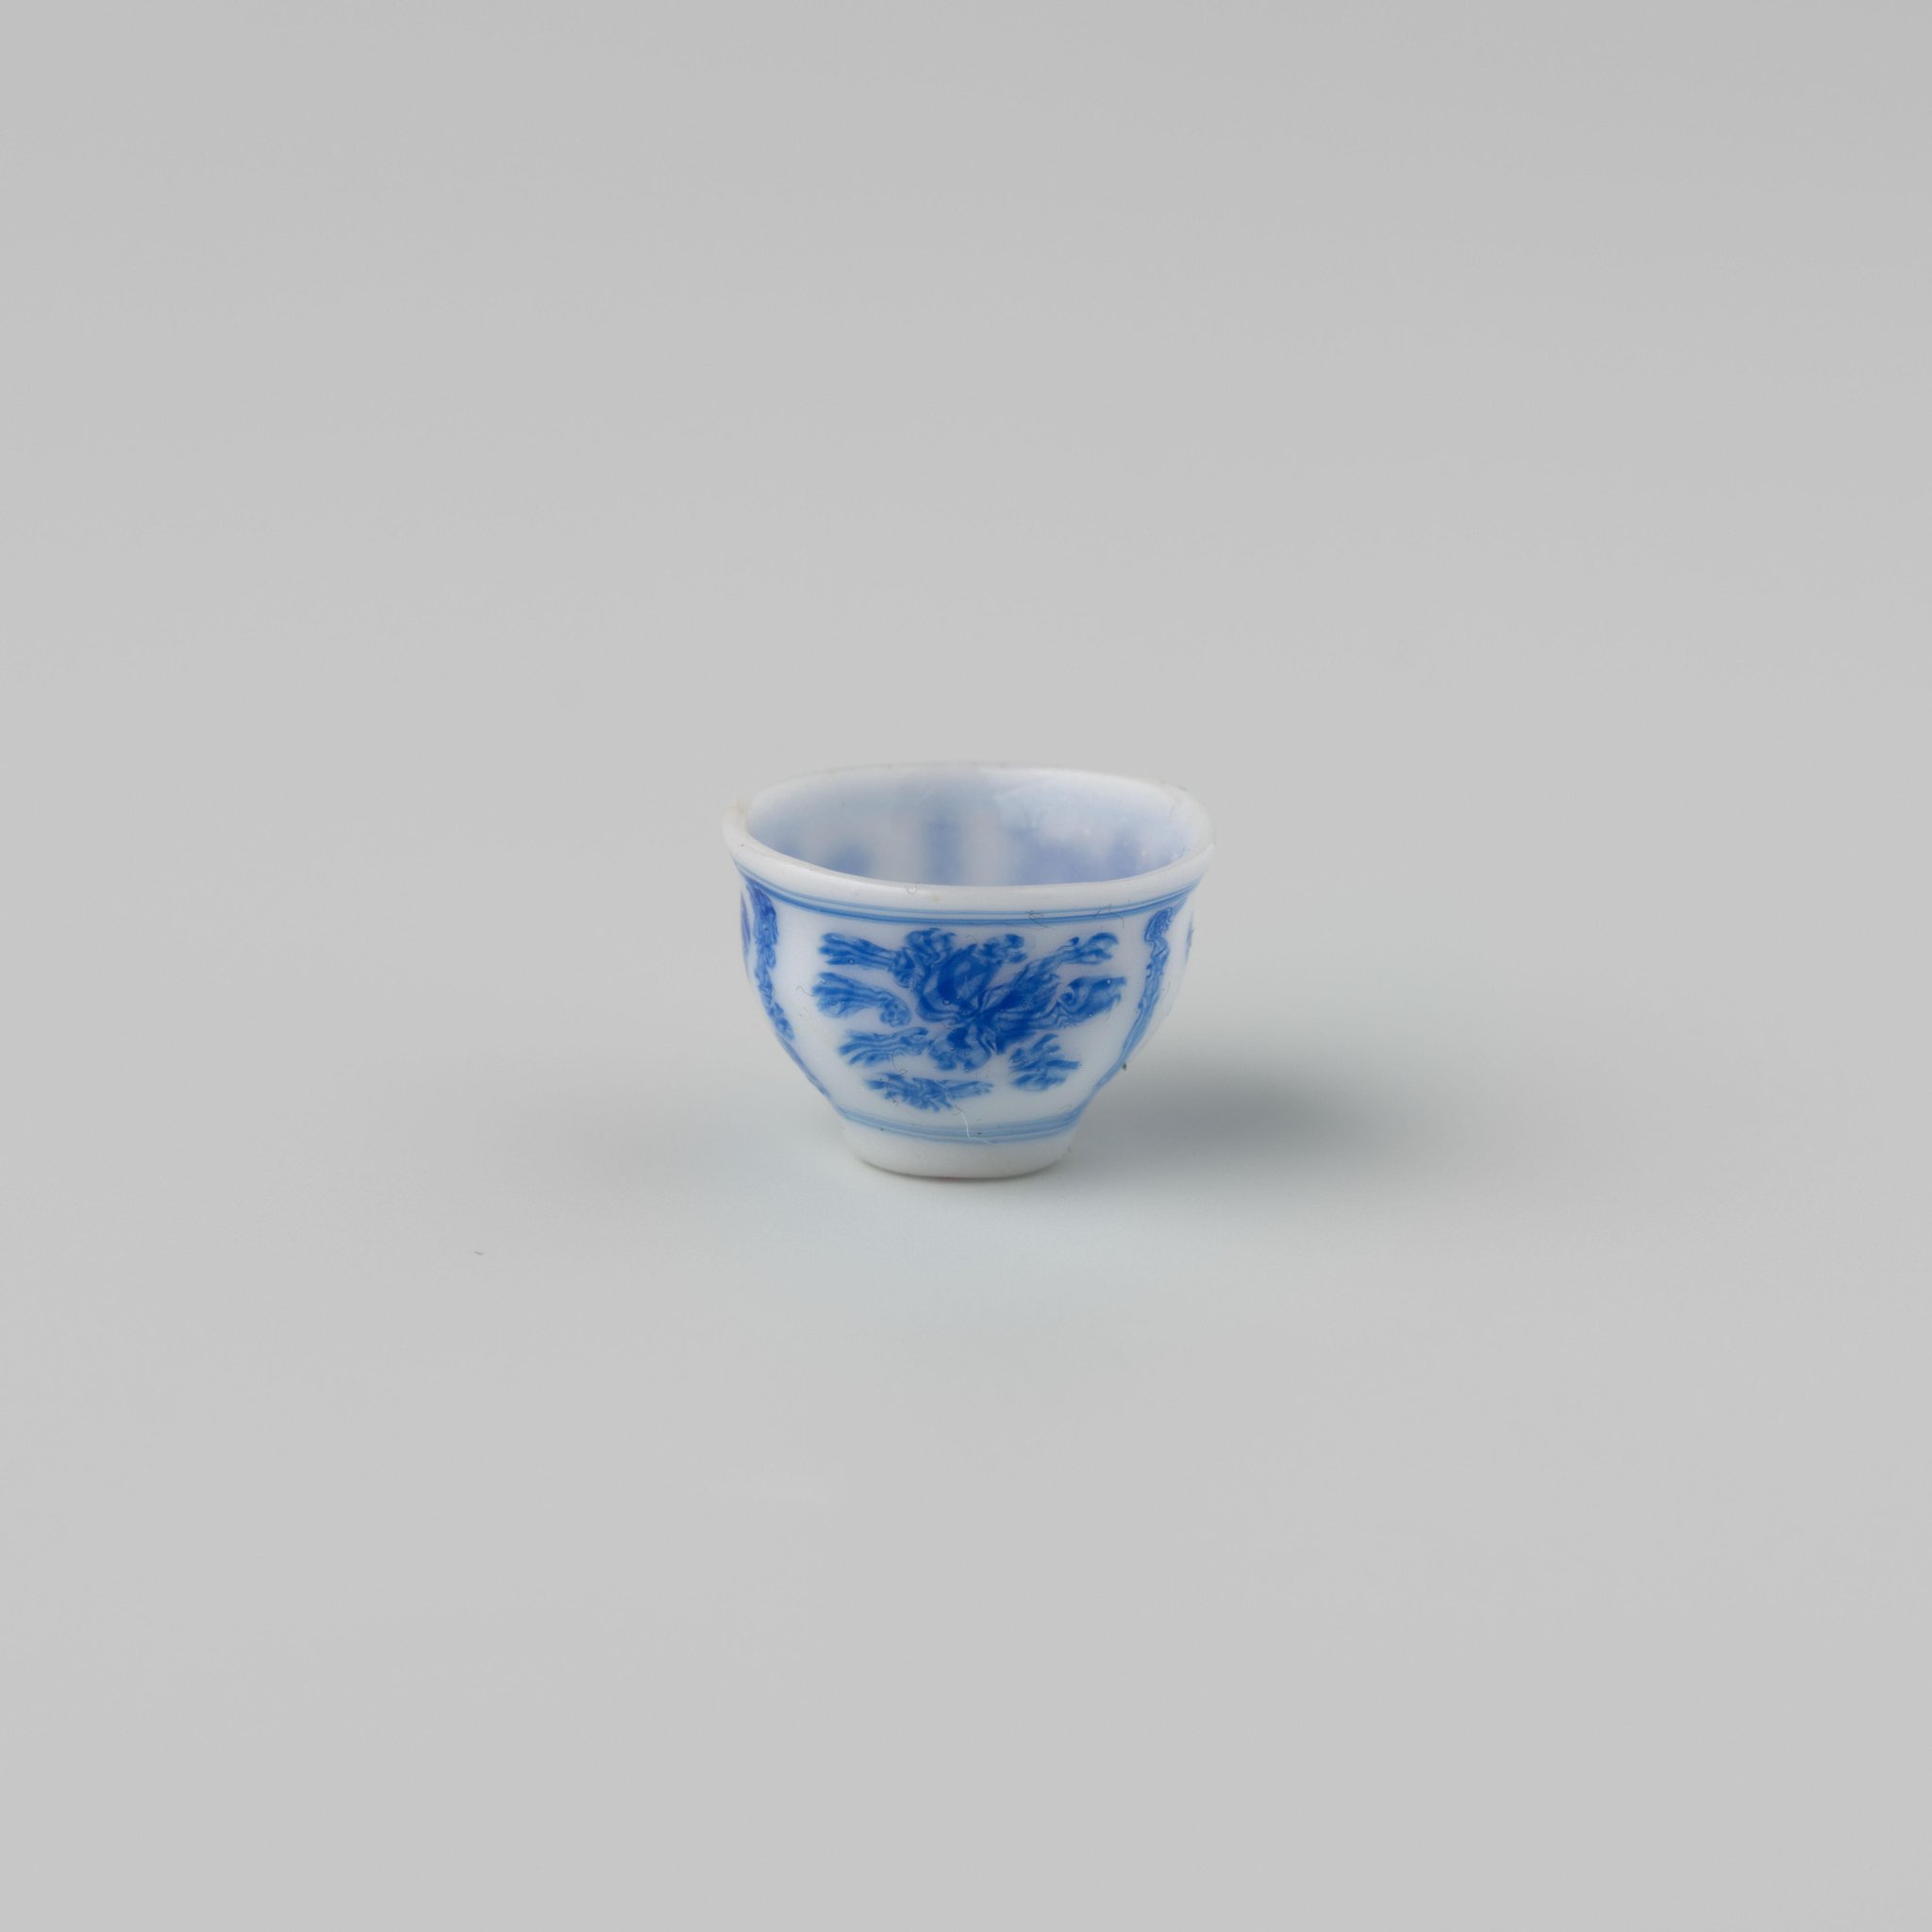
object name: tea cup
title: Theekopje van melkglas met blauwe emailverf beschildering, imitatie Chinees porselein met 'bloem' decoratie in vakken; op standring en met gladde mondrand.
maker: Anonymous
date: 1675-1710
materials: glass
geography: amsterdam